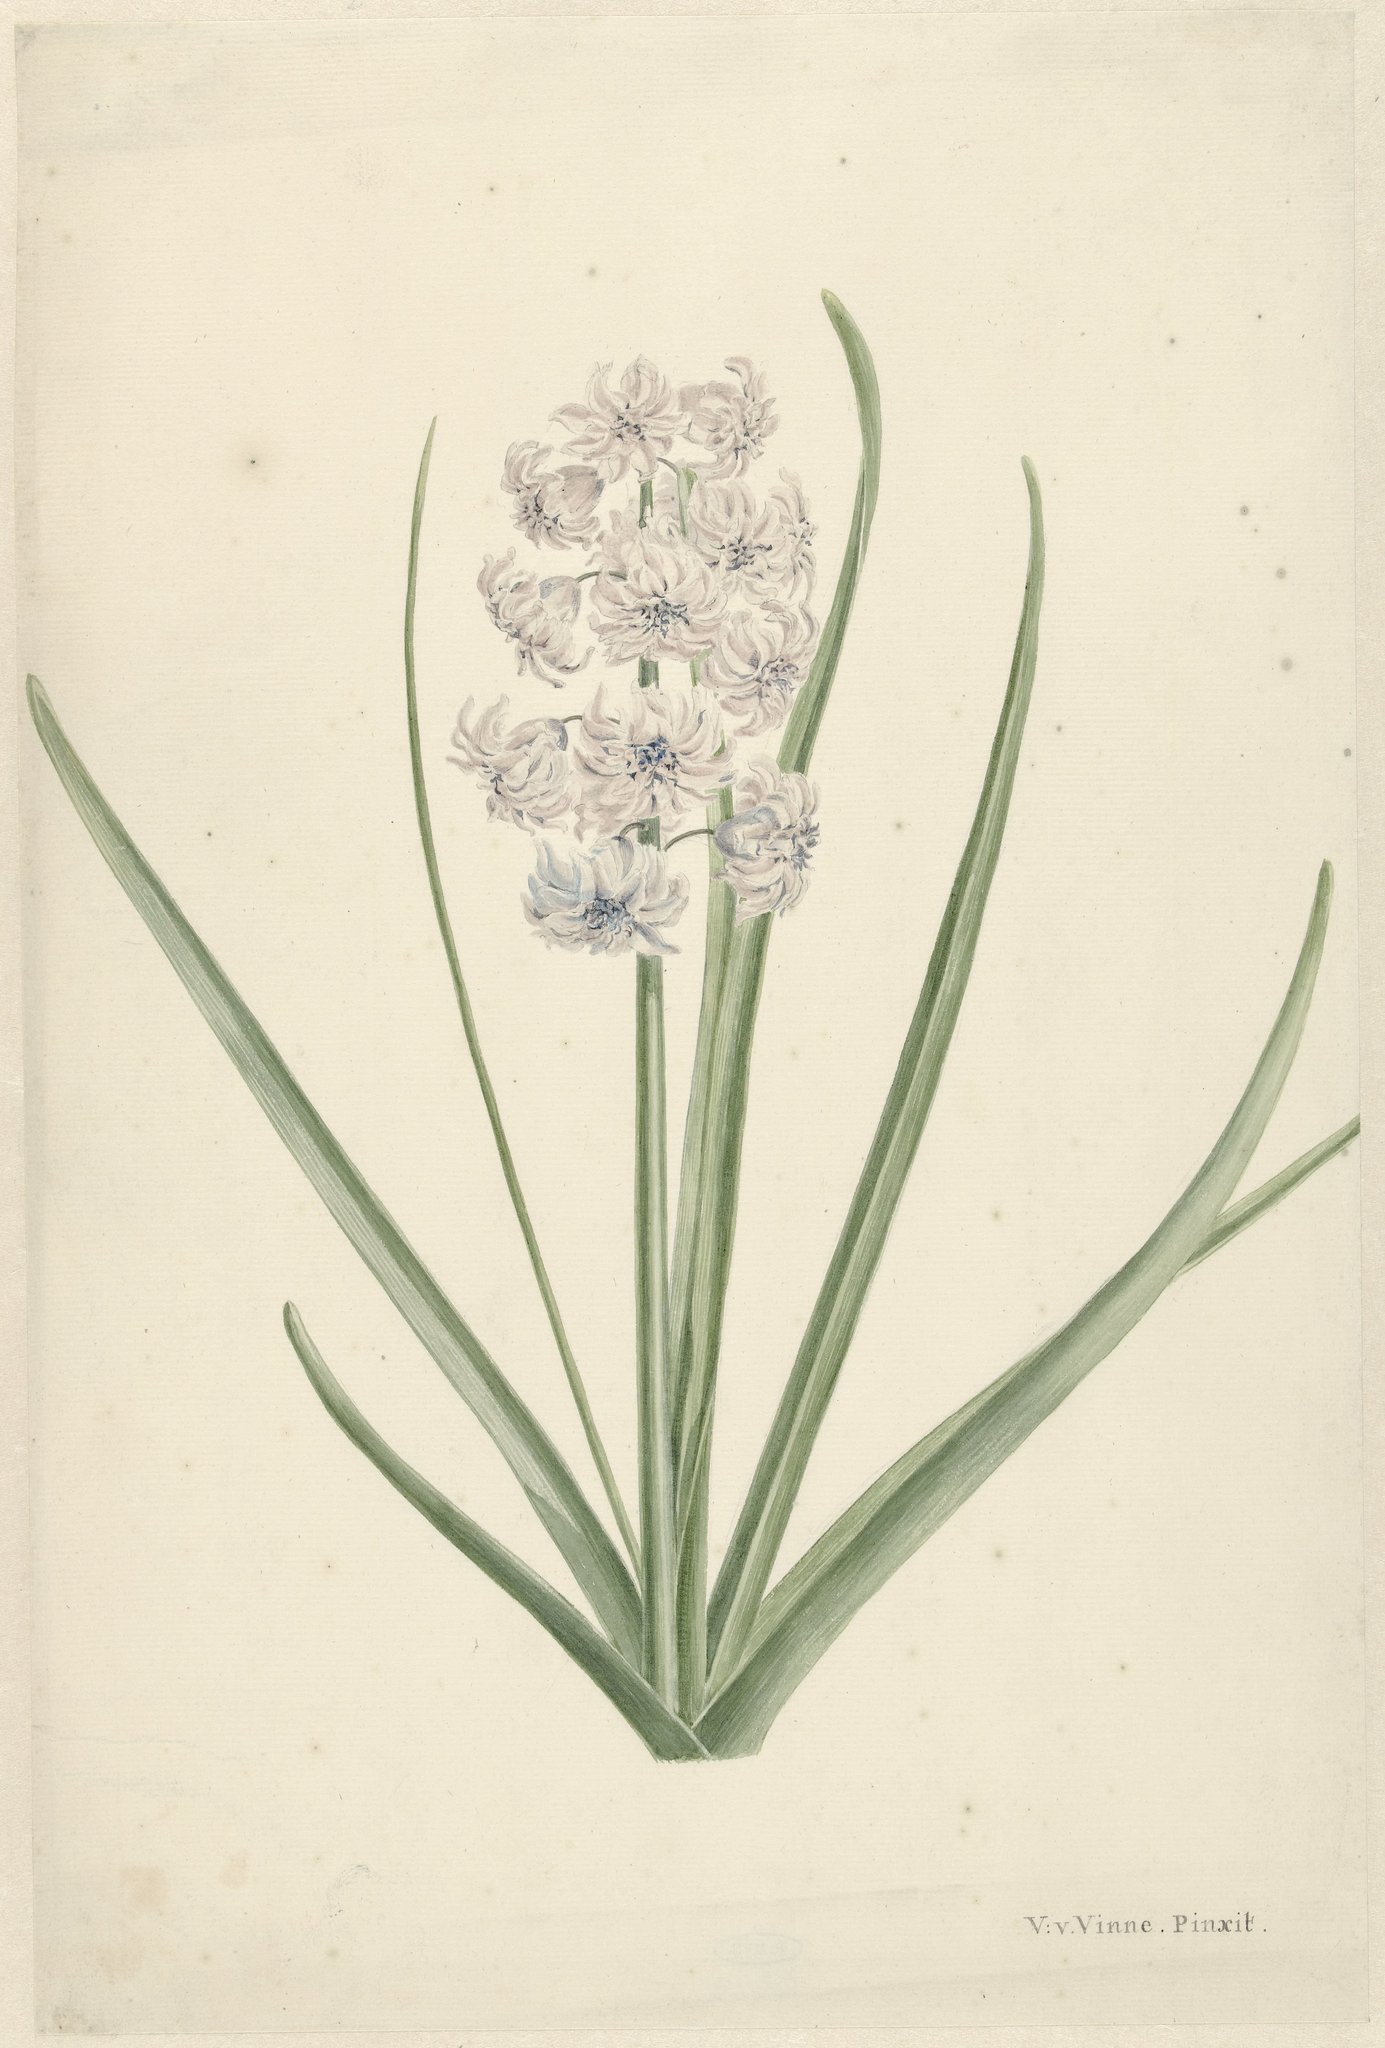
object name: watercolor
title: Wit-lichtblauwe hyacint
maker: vincent jansz. van der vinne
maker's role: draughtsman, print maker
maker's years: 1736-1811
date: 1746-1811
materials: paper, watercolor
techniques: brush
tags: flowers: hyacinth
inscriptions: inscription: ‘V:v.Vinne. Pinxit’